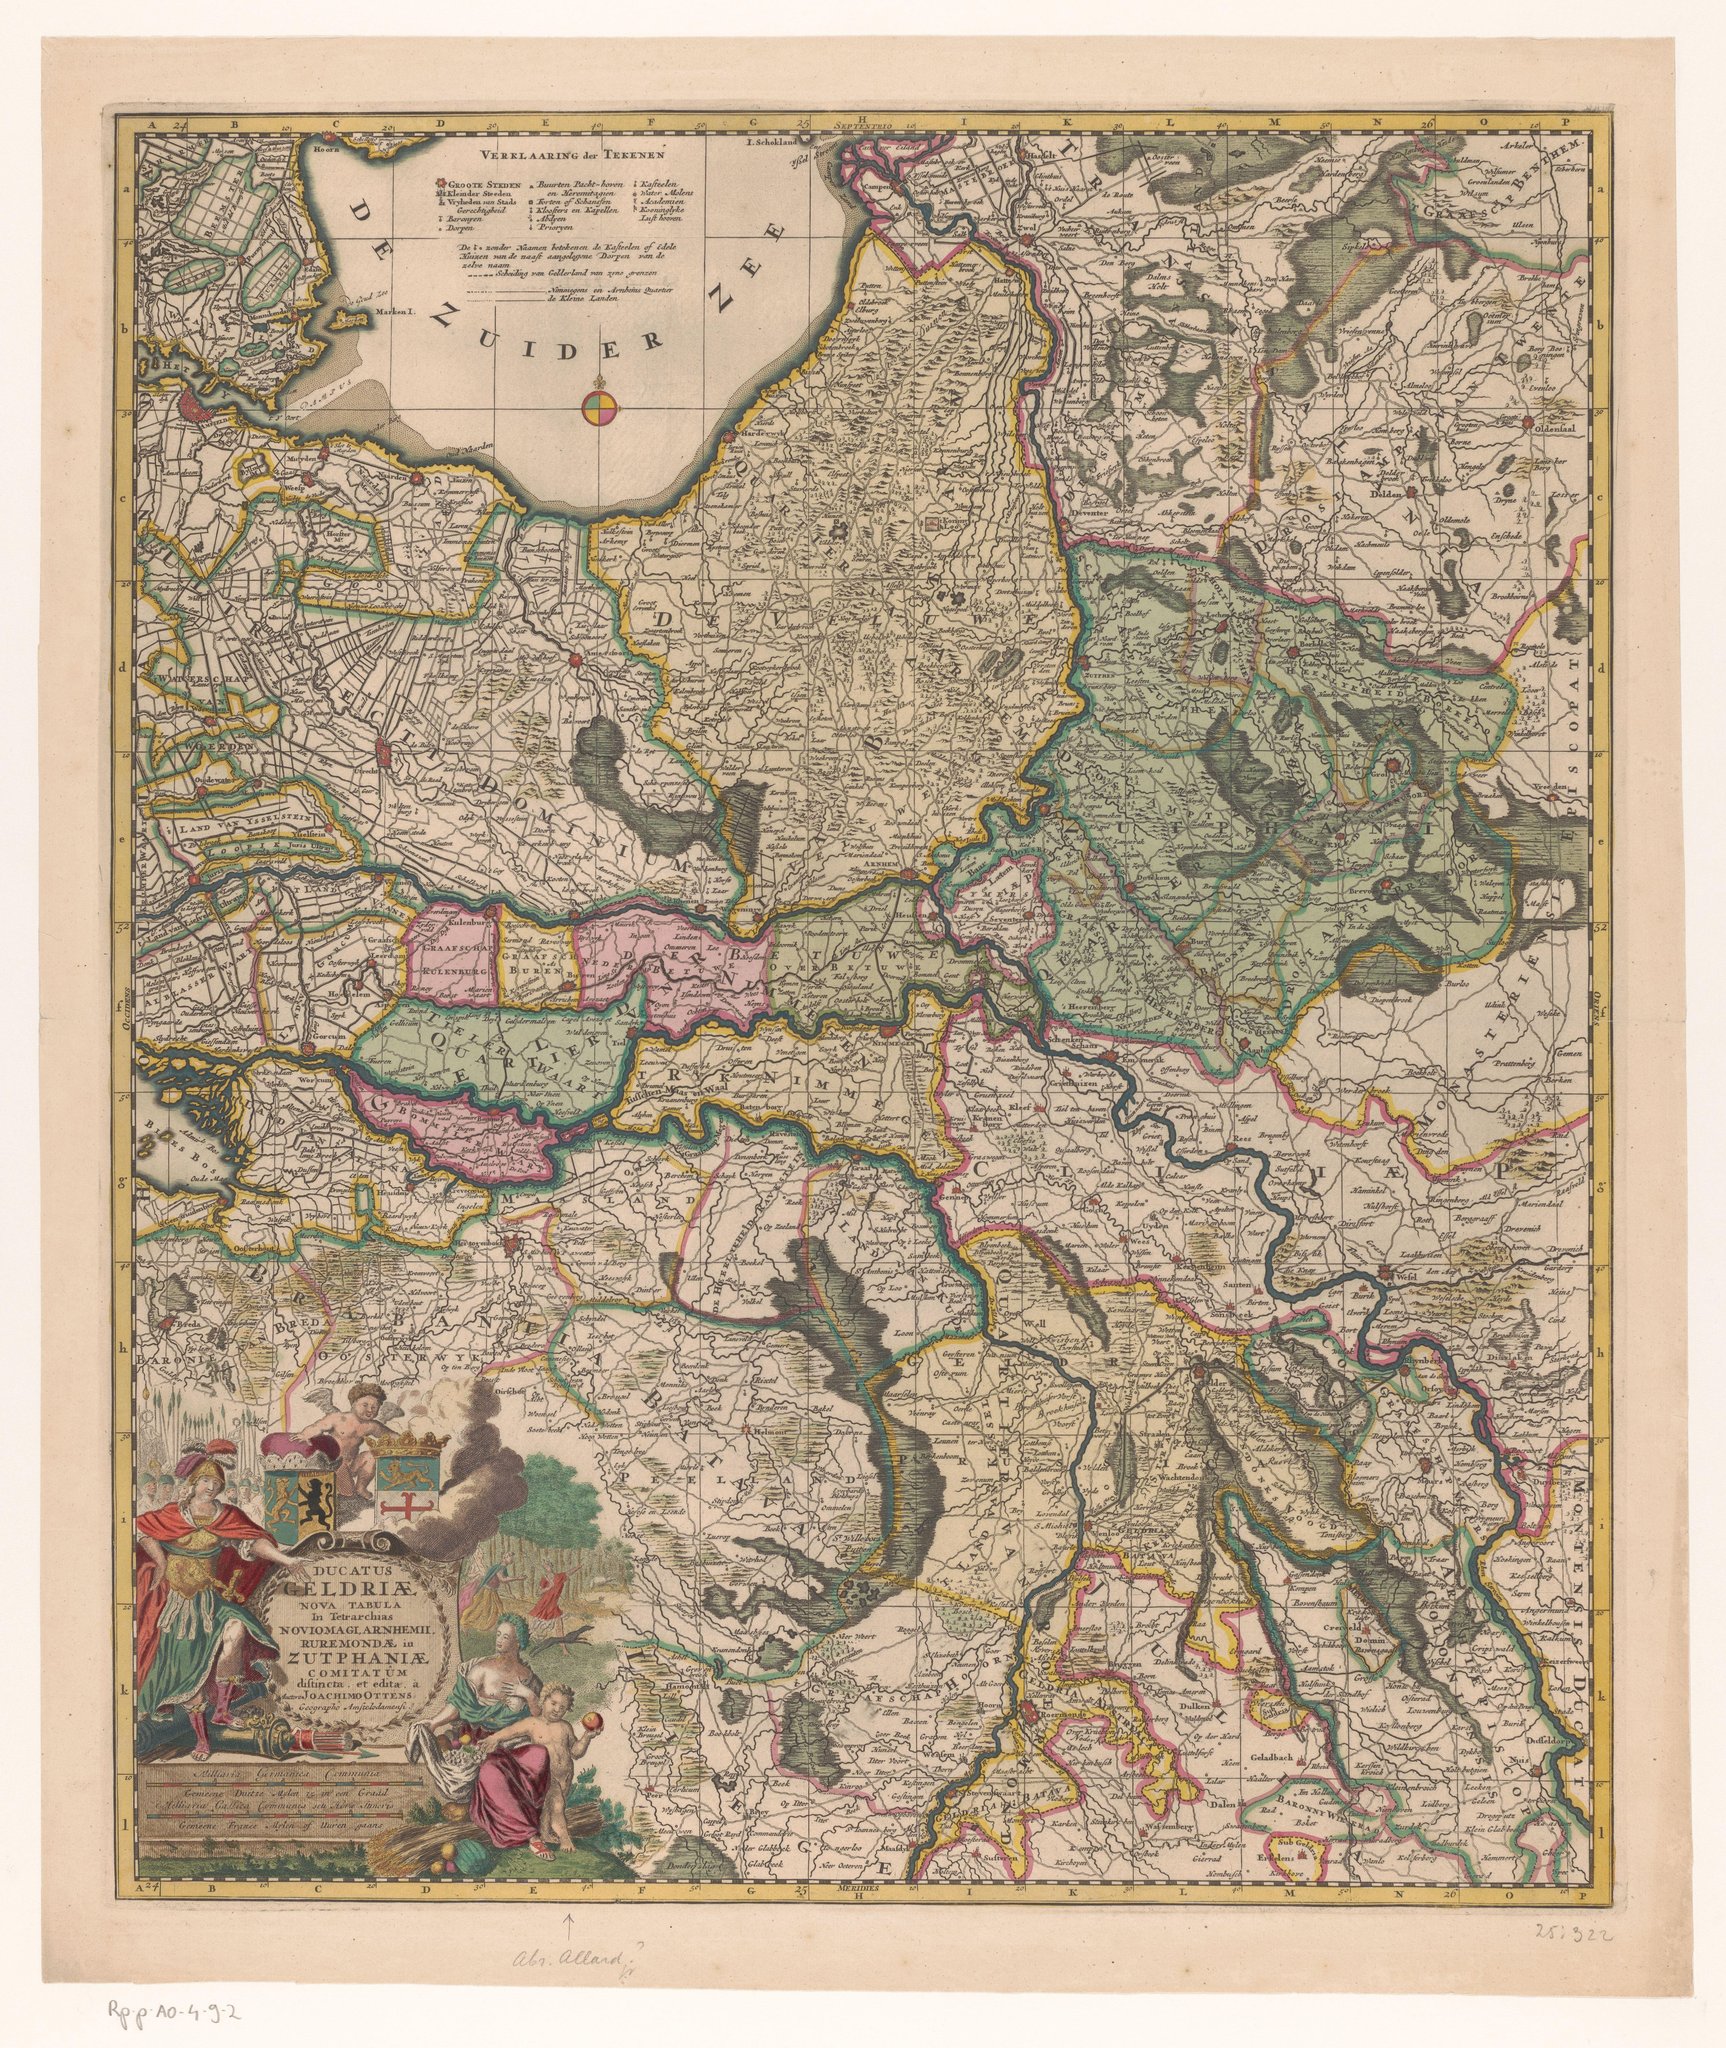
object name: map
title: Ducatus Geldriae novus tabula in tetrarchias Noviomagi (...)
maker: abraham allard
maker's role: print maker, publisher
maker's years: 1676-1725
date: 1725-1750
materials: paper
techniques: engraving, etching, hand coloring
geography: amsterdam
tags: coat of arms (as symbol of the state, etc.) (+ city; municipal), maps of separate countries or regions, hunting, chase, coat of arms (as symbol of the state, etc.) (+ province; provincial), gelderland, guelders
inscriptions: collector's mark: Lugt 2228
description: Linksonder de titelcartouche en twee schaalstokken: 4 Gemeene Duitse Mylen 15 in een graad / 5 Gemeene France Mylen of Uuren gaans. Boven de cartouche het wapen van Gelre en van de stad Zutphen. Rond de cartouche figuren en een jachttafereel. Linksboven een legenda. De kaart is voorzien van een zoekrooster en een gradenverdeling langs de randen.